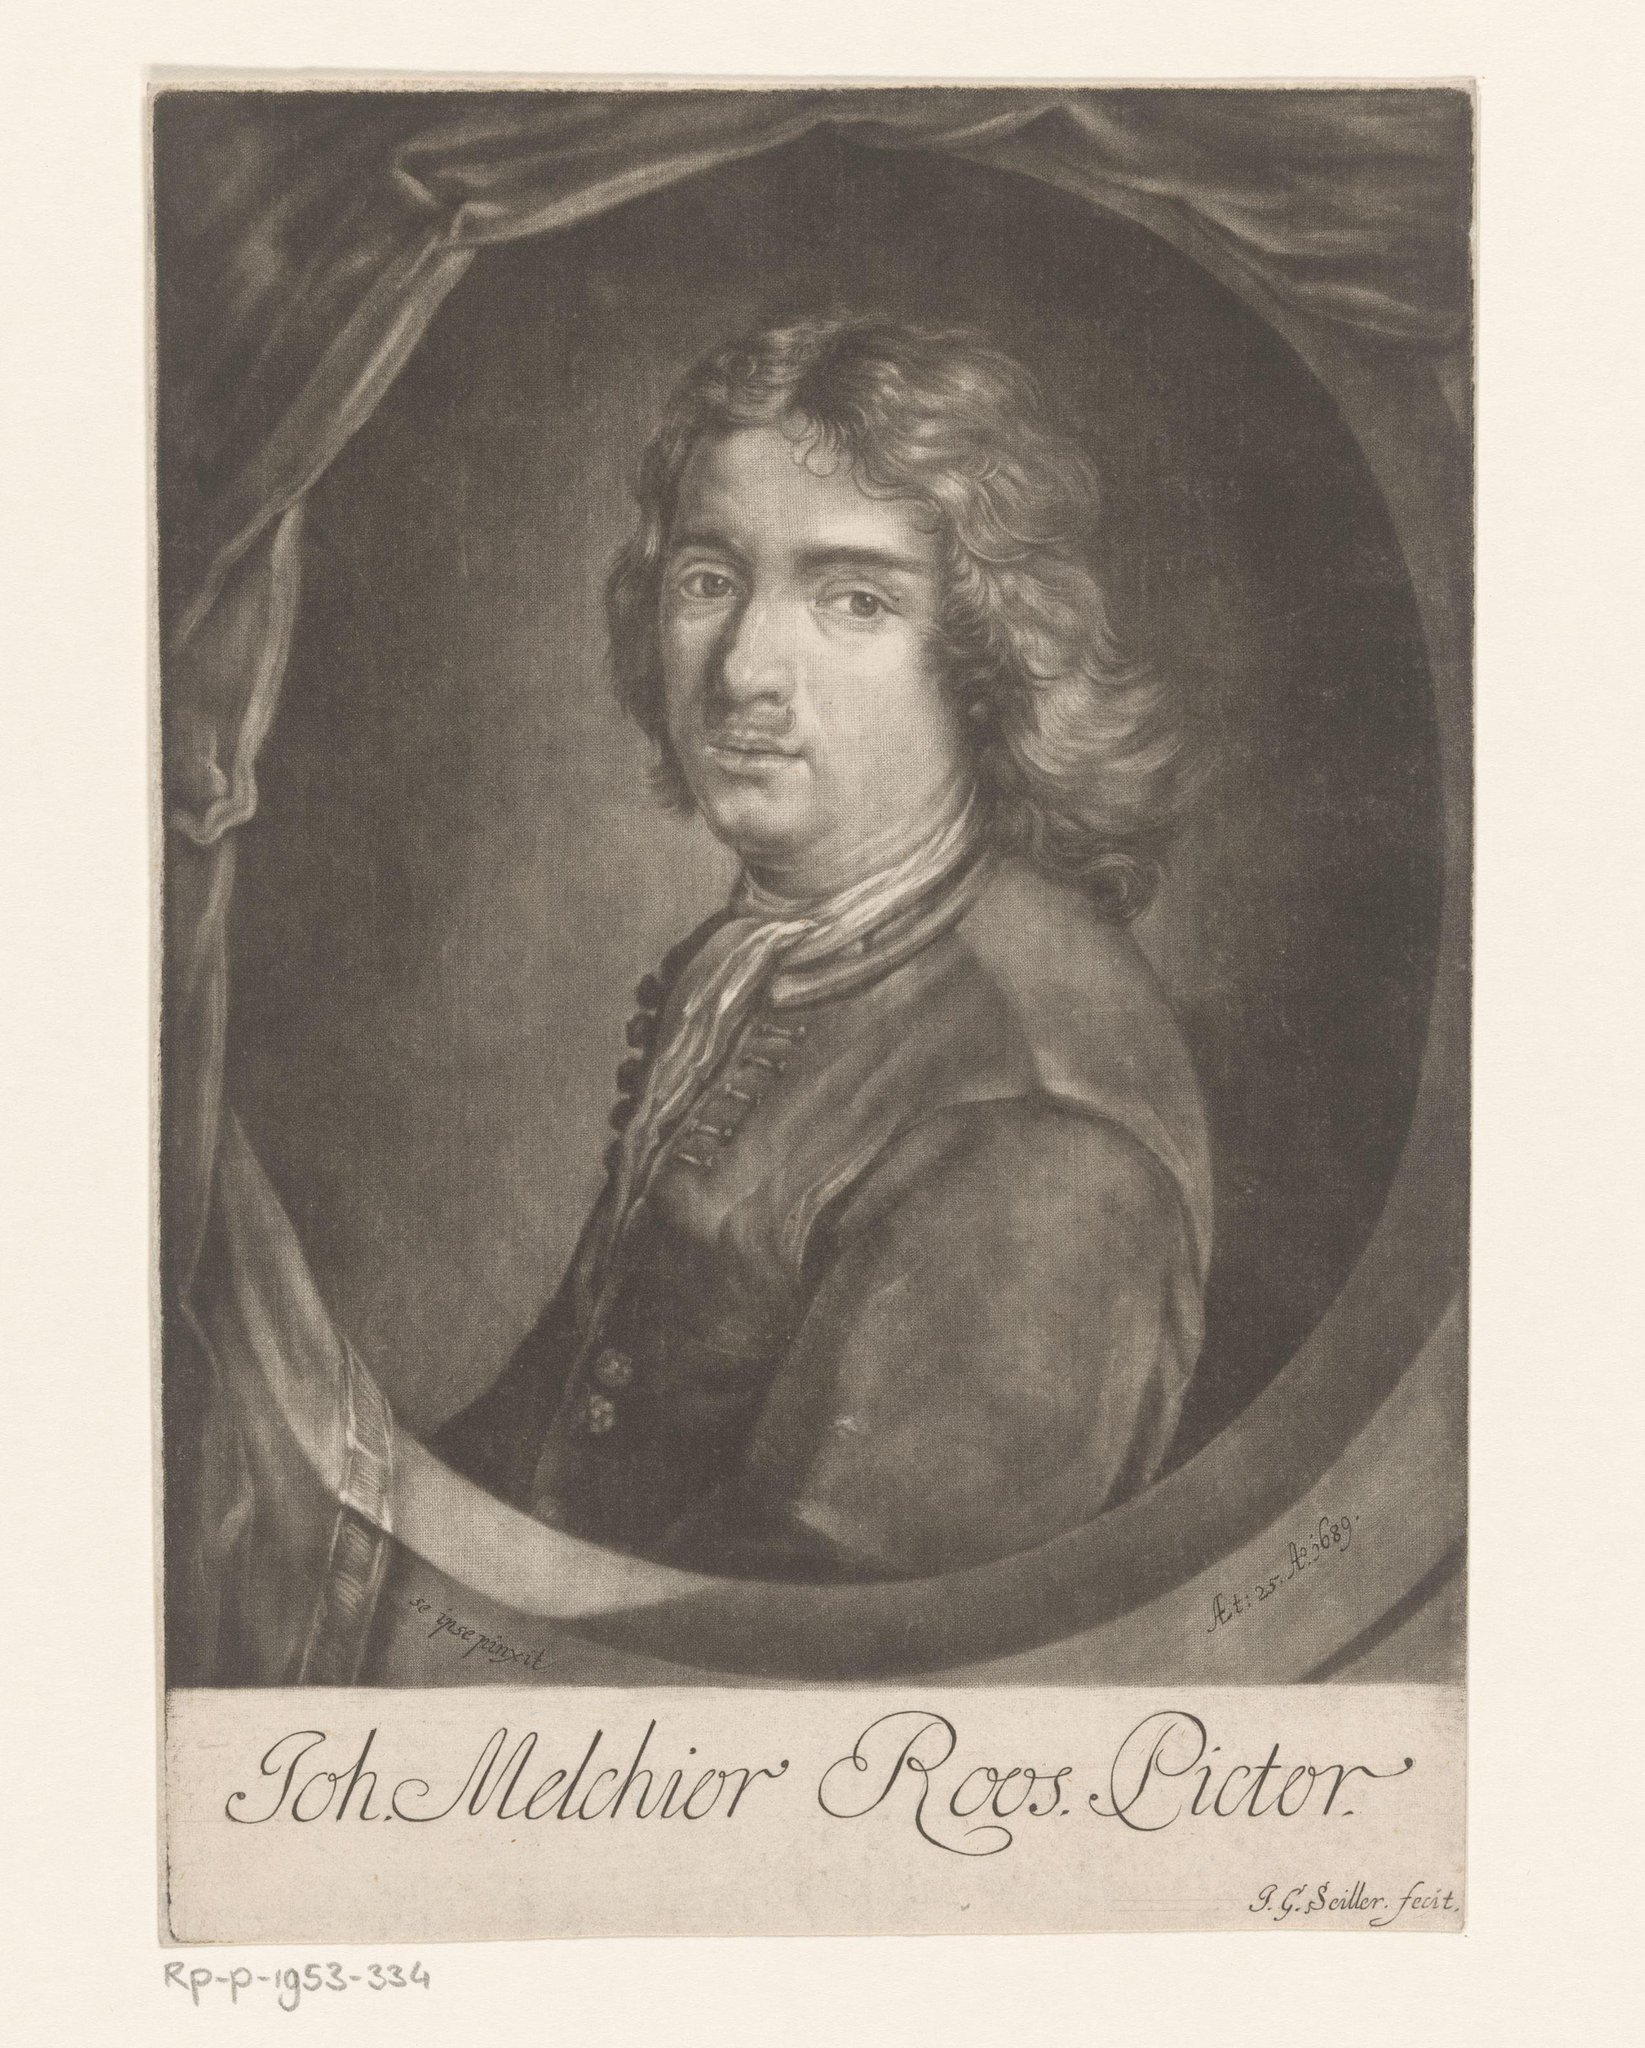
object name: print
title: Portret van Johann Melchior Roos op 25-jarige leeftijd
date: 1689-1740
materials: paper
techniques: mezzotint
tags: painter, print maker, historical persons, portrait, self-portrait of painter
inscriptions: collector's mark: Lugt 2228